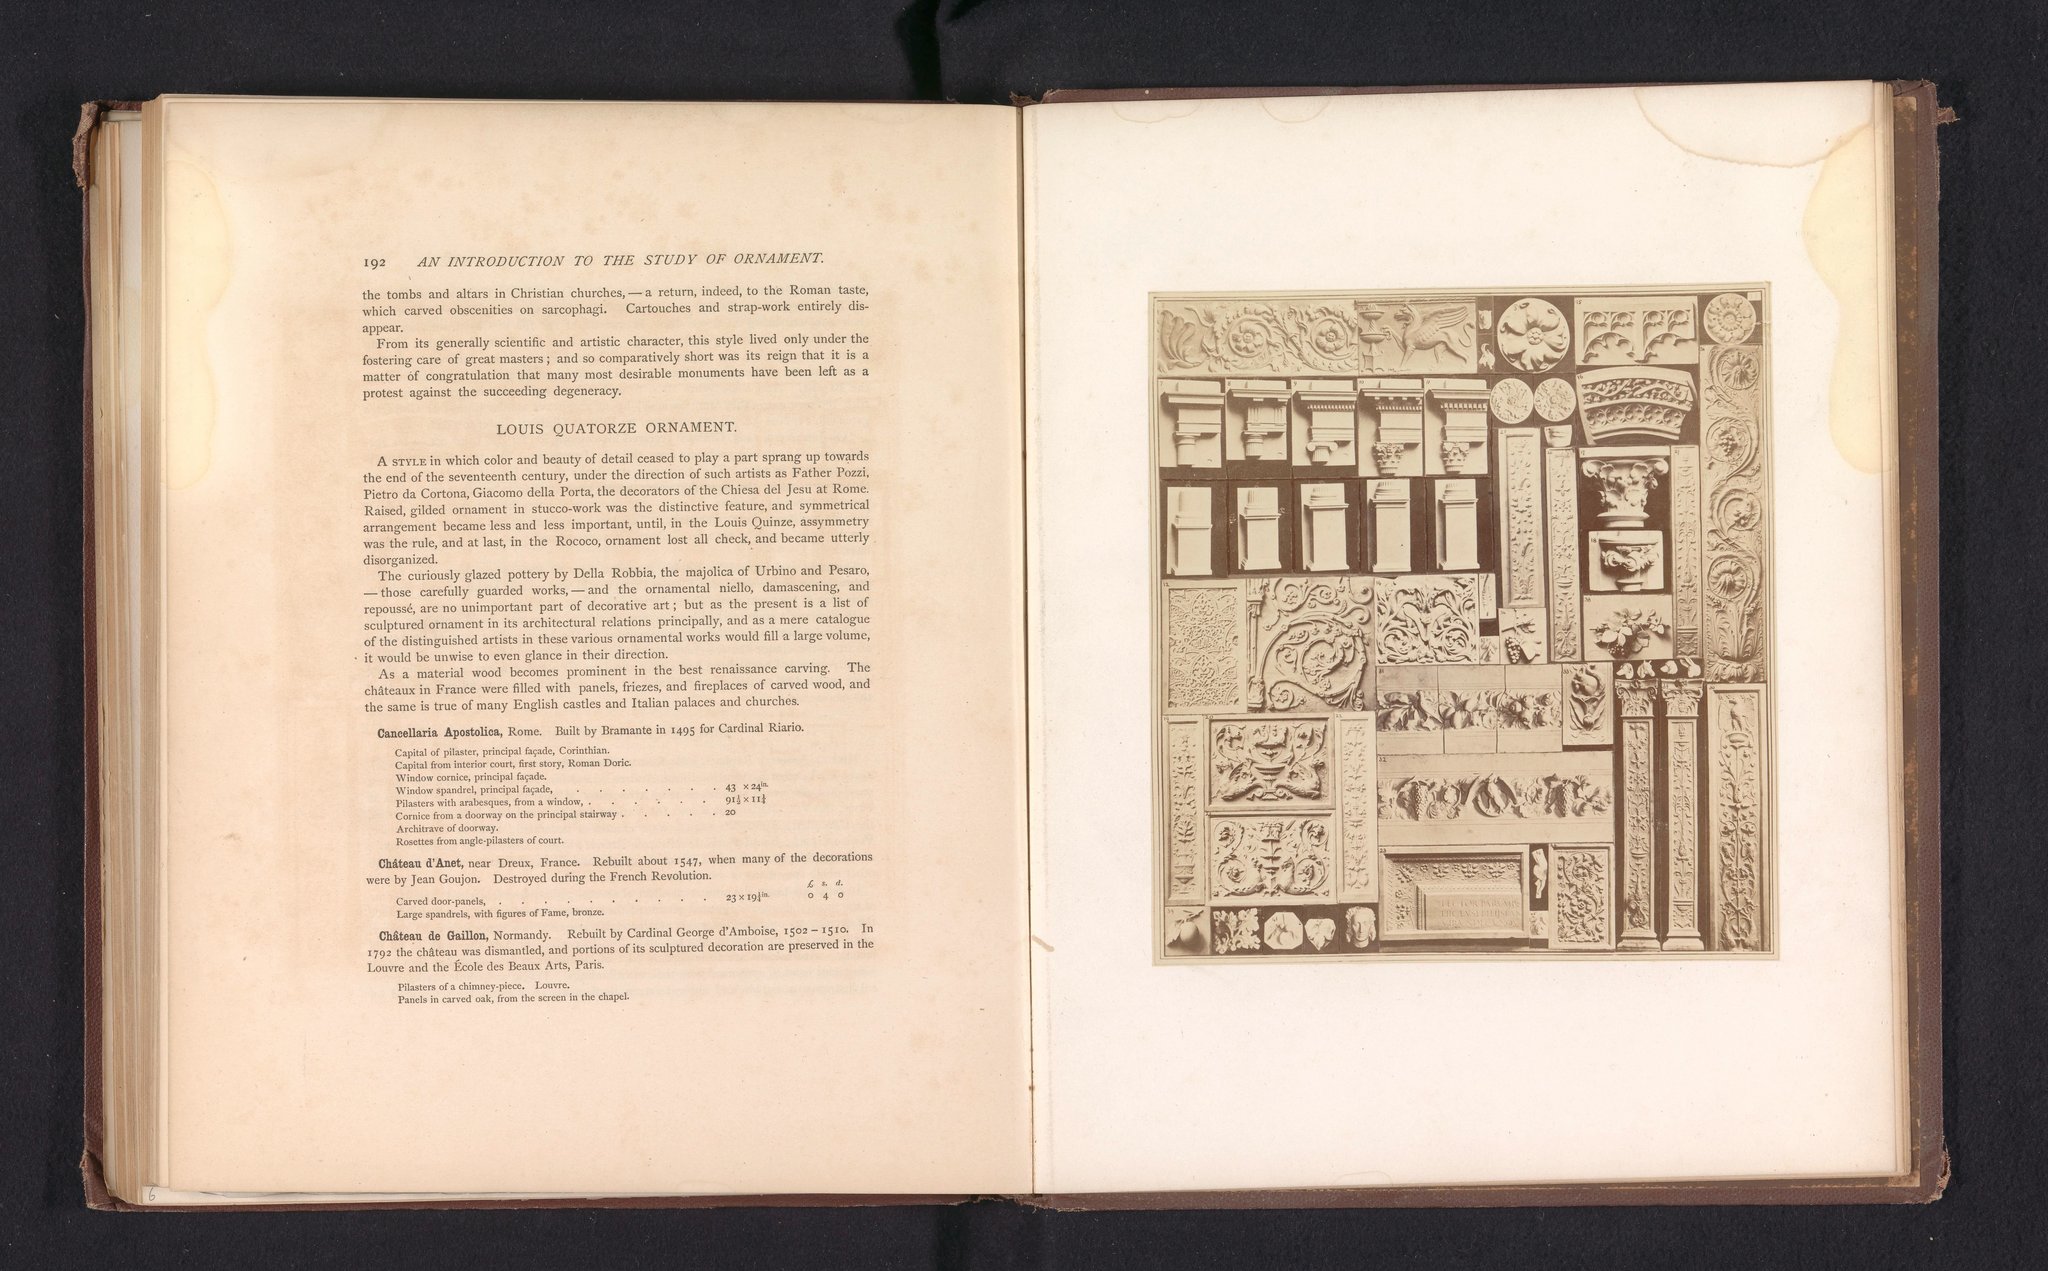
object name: photograph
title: Afgietsels van antieke bouwfragmenten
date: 1864-1874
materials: photographic support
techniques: albumen print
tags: column, pillar ~ architecture, stylistic and formal differentiation of art, architectural detail